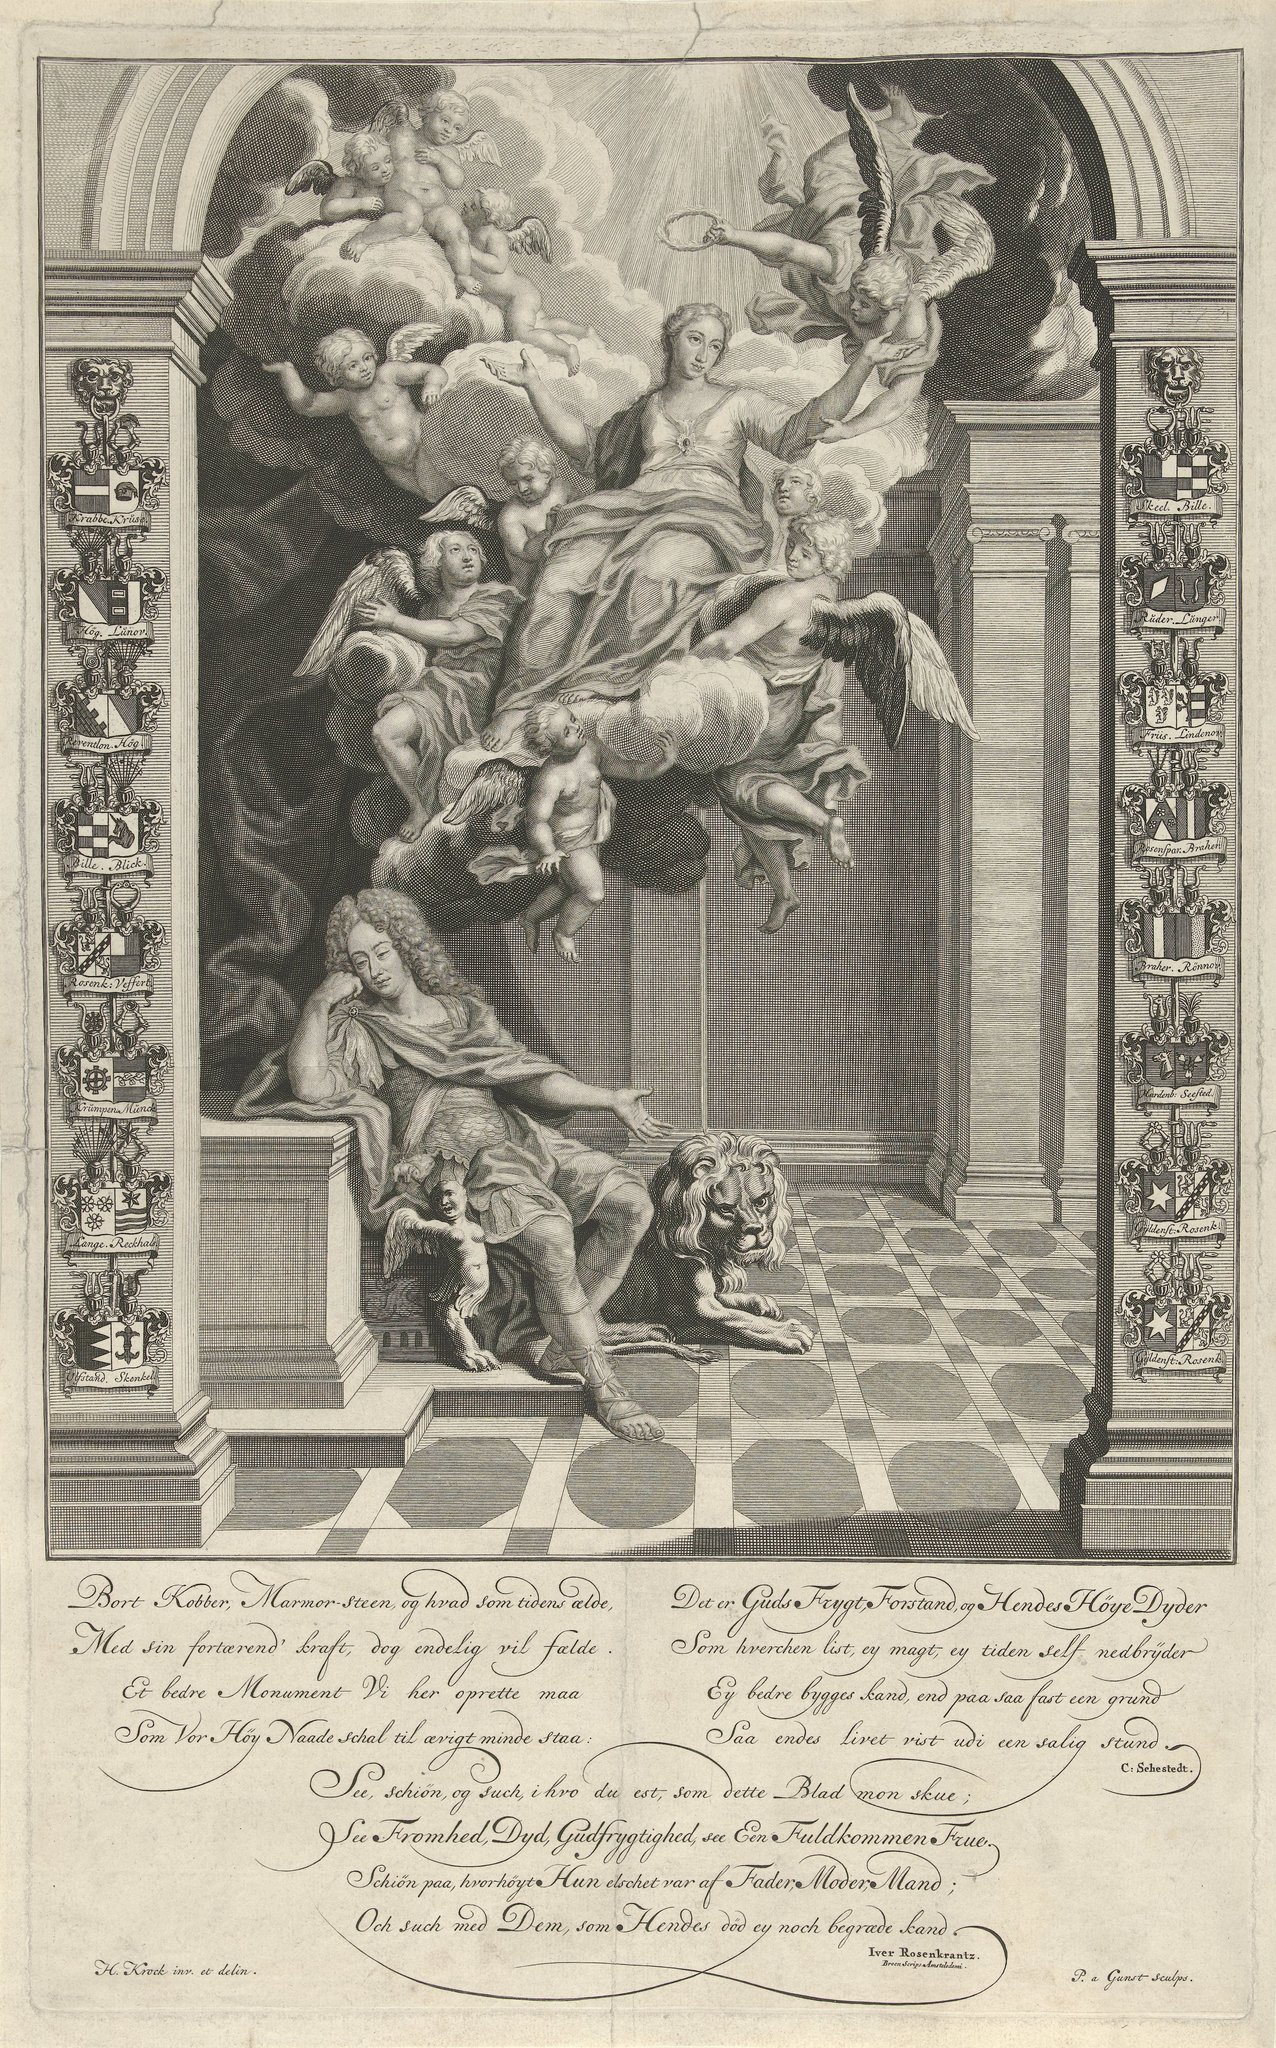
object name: print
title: Portret van een koning Frederick IV van Denemarken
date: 1659-1731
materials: paper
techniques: engraving, etching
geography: amsterdam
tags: copenhagen (city), frederik iv (koning van denemarken en noorwegen), beasts of prey, predatory animals: lion (+ animals used symbolically), apotheosis (or ascension) of individuals, angels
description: Frederick IV, koning van Denemarken, leunt tegen zijn troon. Aan zijn voeten een leeuw. Boven wordt zijn vrouw, koningin Louise van Mecklenburg, door engelen naar de hemel gedragen en met een lauwerkrans gekroond. Aan weerszijden van de voorstelling acht wapenschilden van Deense steden. De prent heeft een Deens onderschrift in rijmvorm.